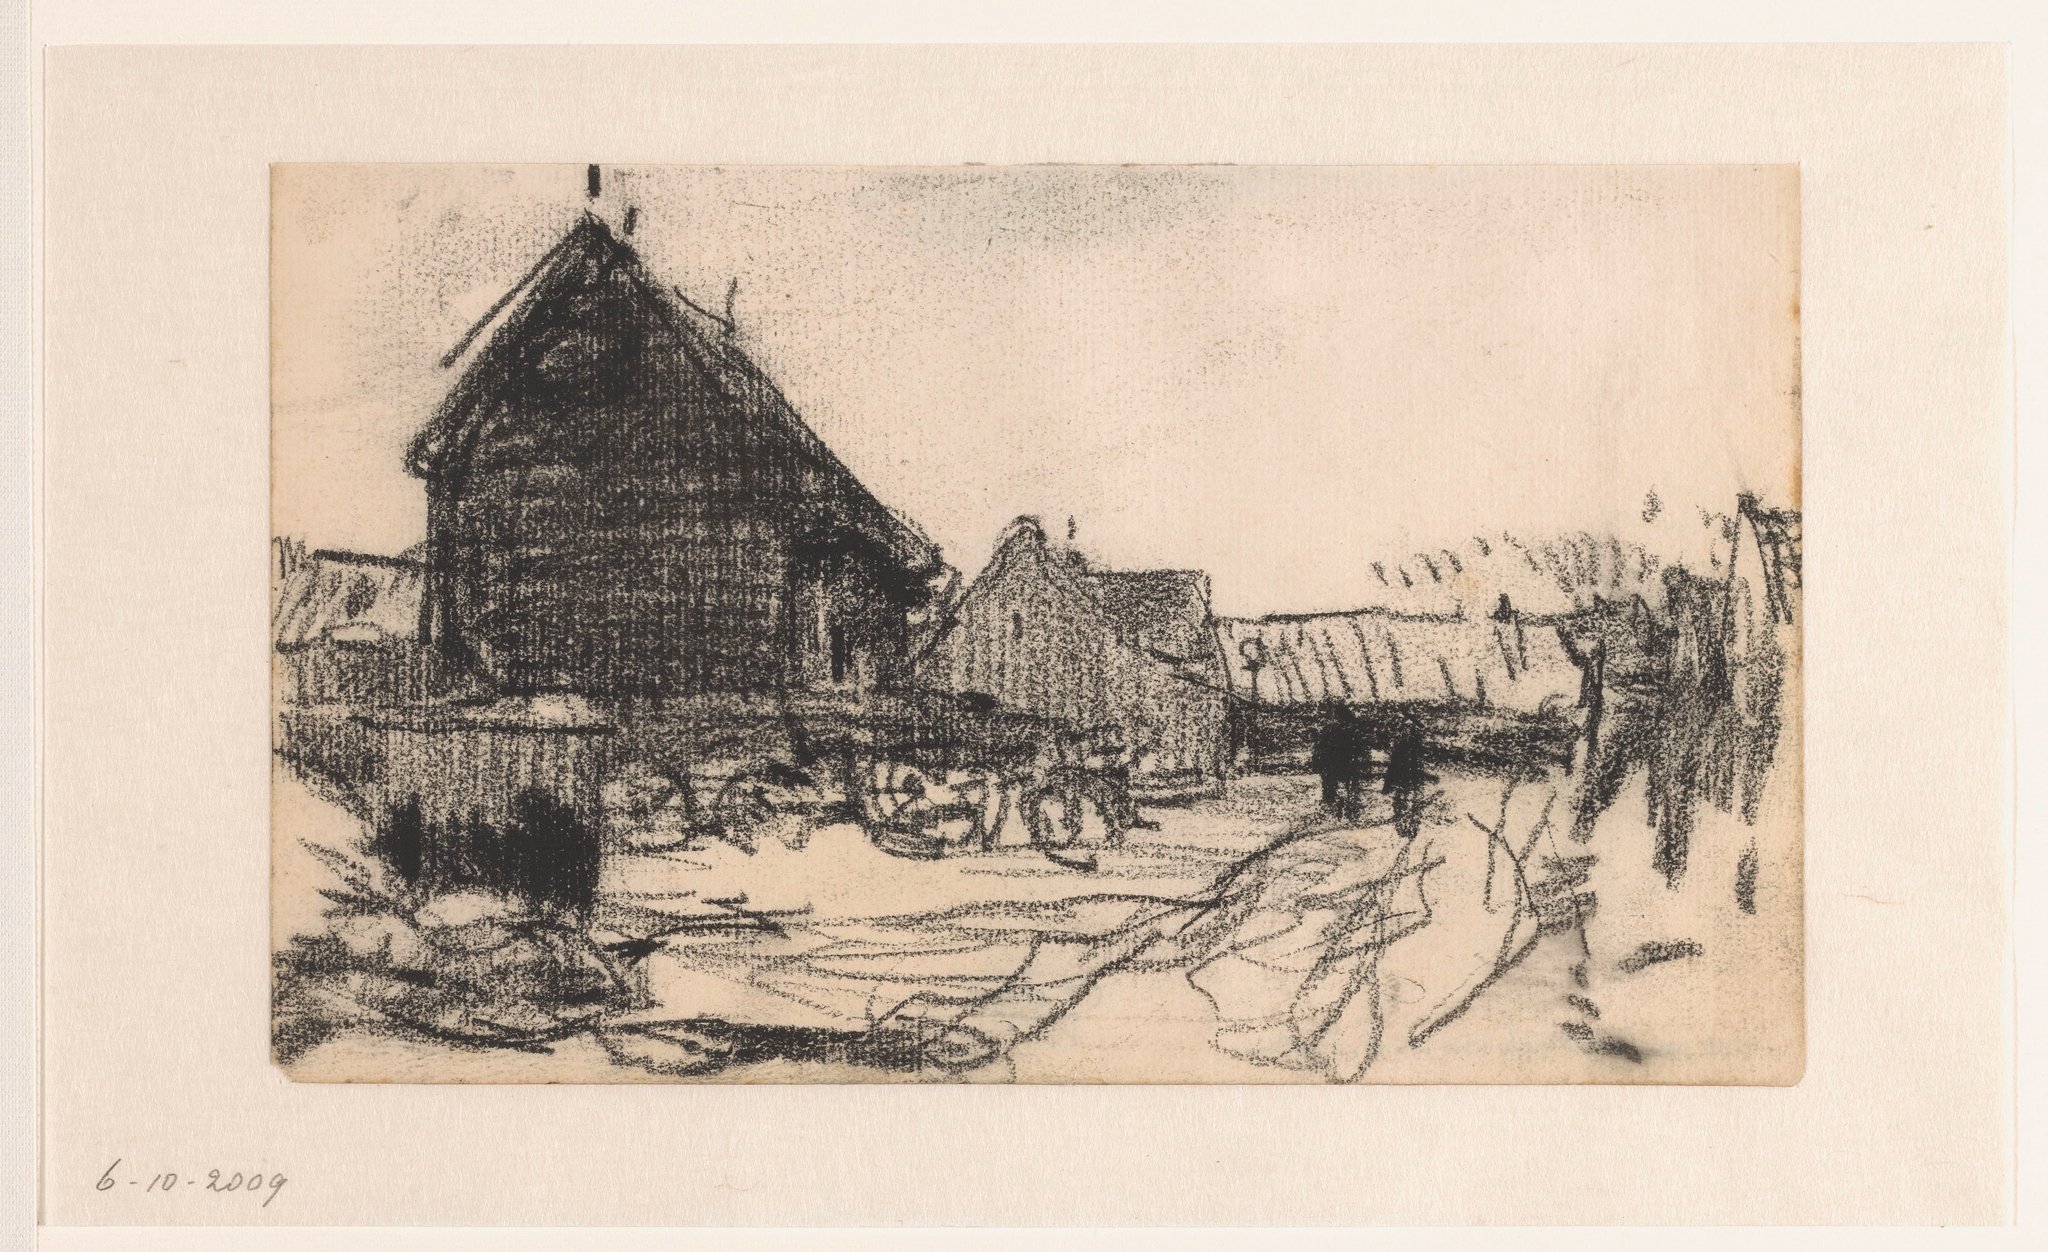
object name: drawing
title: Dorpsgezicht met karren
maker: willem bastiaan tholen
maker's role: draughtsman, painter, print maker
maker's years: 1860-1931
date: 1870-1931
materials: chalk, paper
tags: village